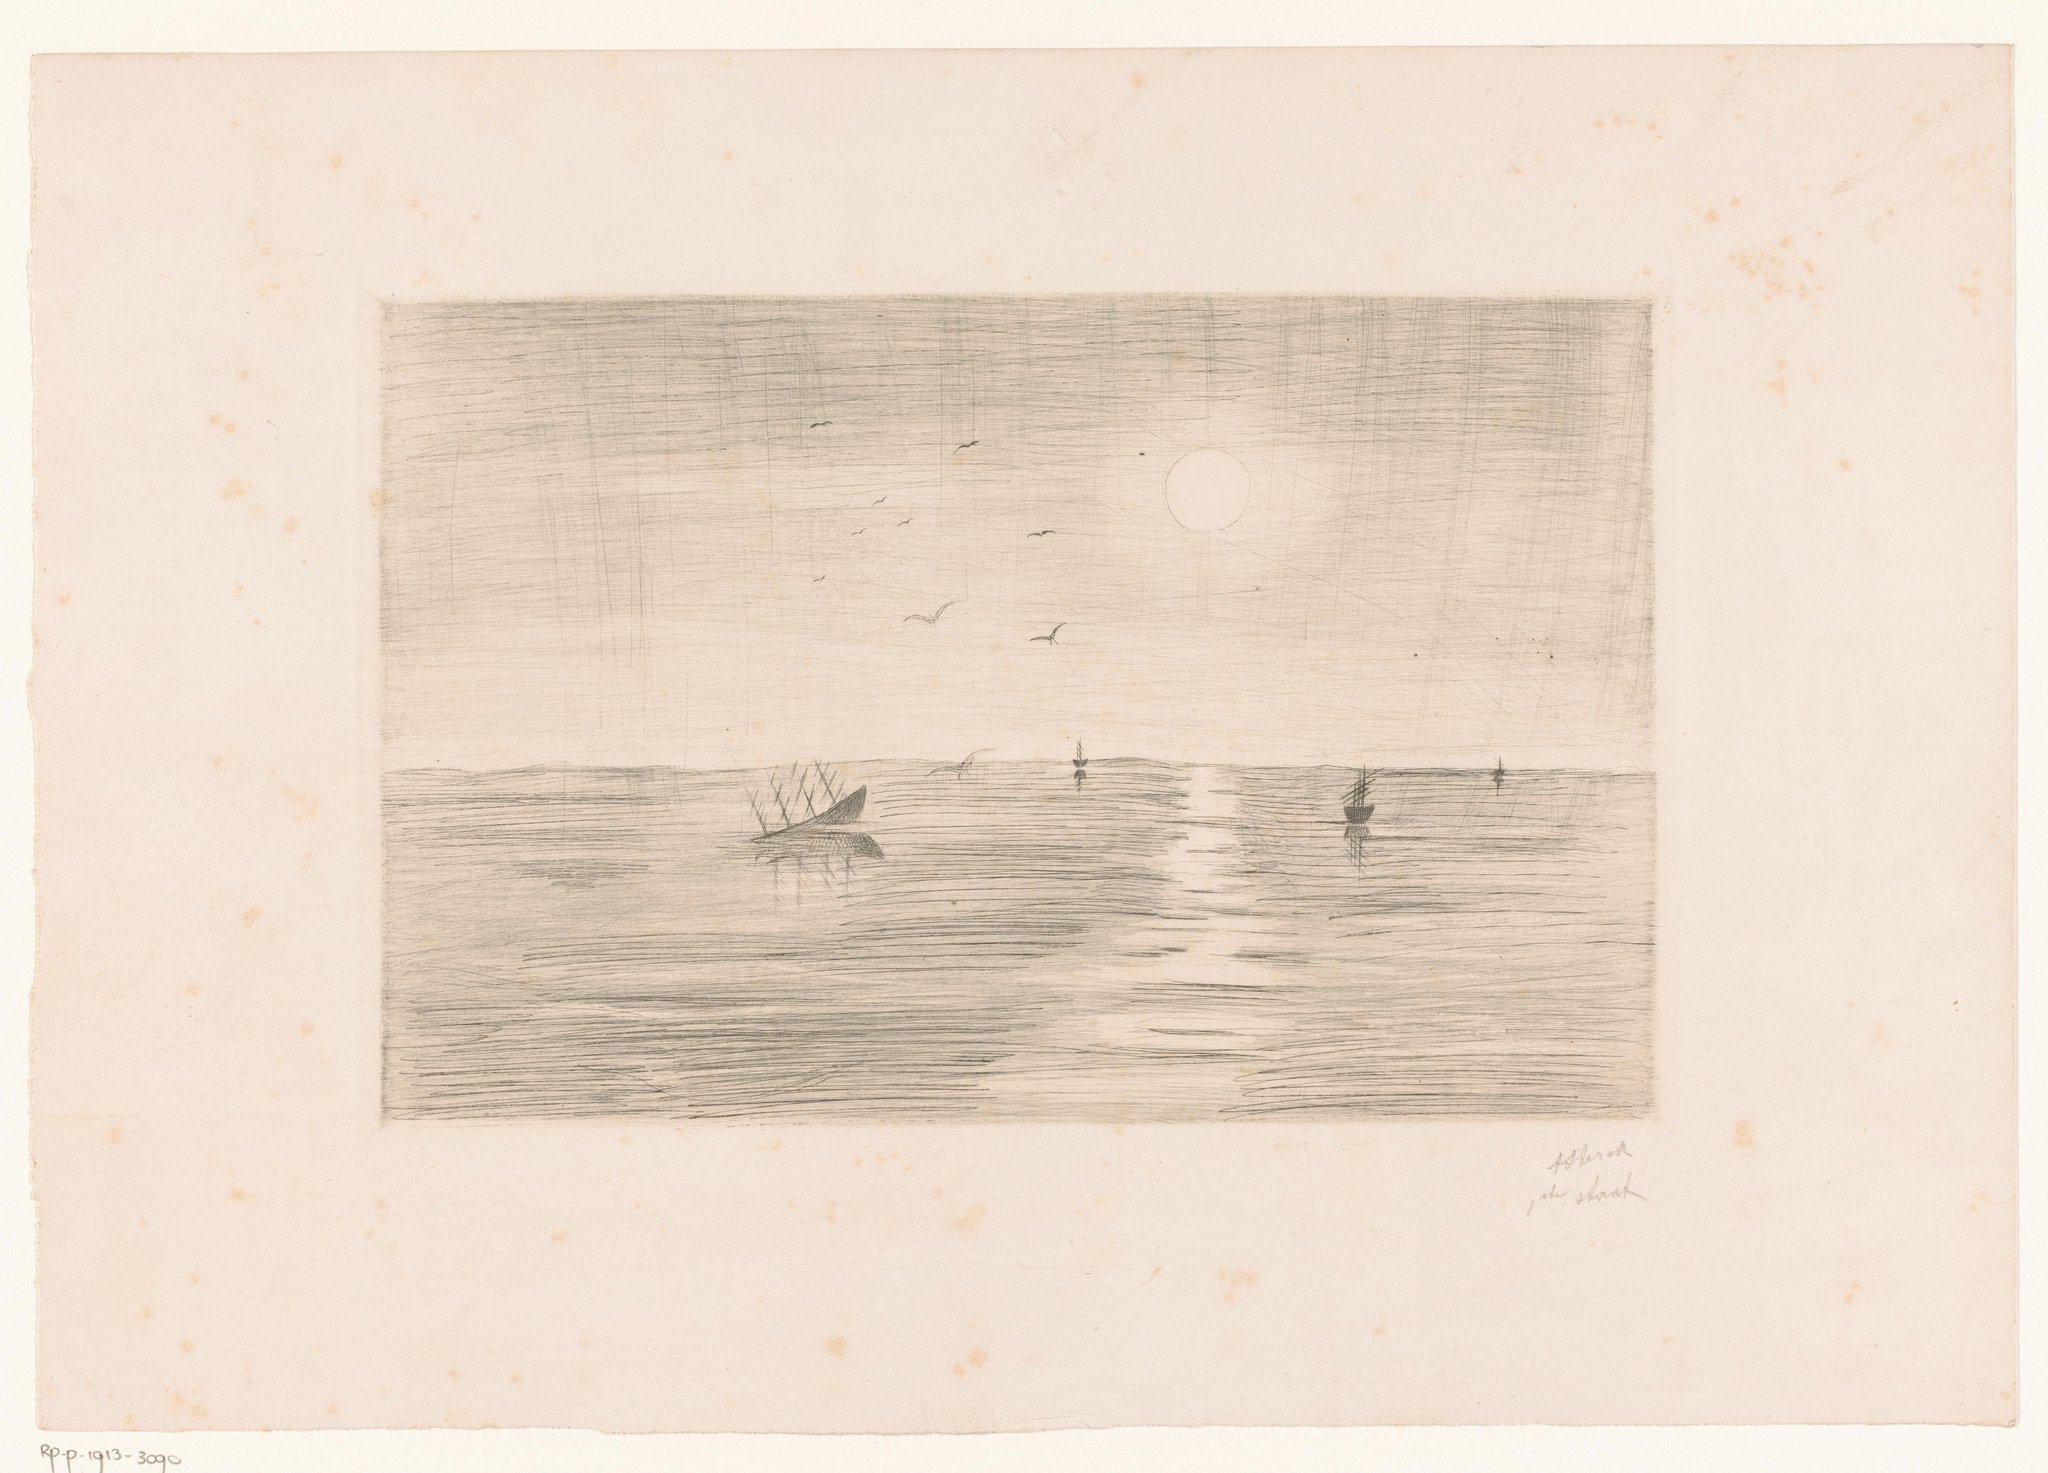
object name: print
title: Nachtelijk zeegezicht met enkele schepen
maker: arthur sterck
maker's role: print maker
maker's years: 1868-1897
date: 1894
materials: paper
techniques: etching, intaglio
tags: sailing-ship, sailing-boat, sea (seascape)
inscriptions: collector's mark: Lugt 2228, annotation: ‘1ste staat’